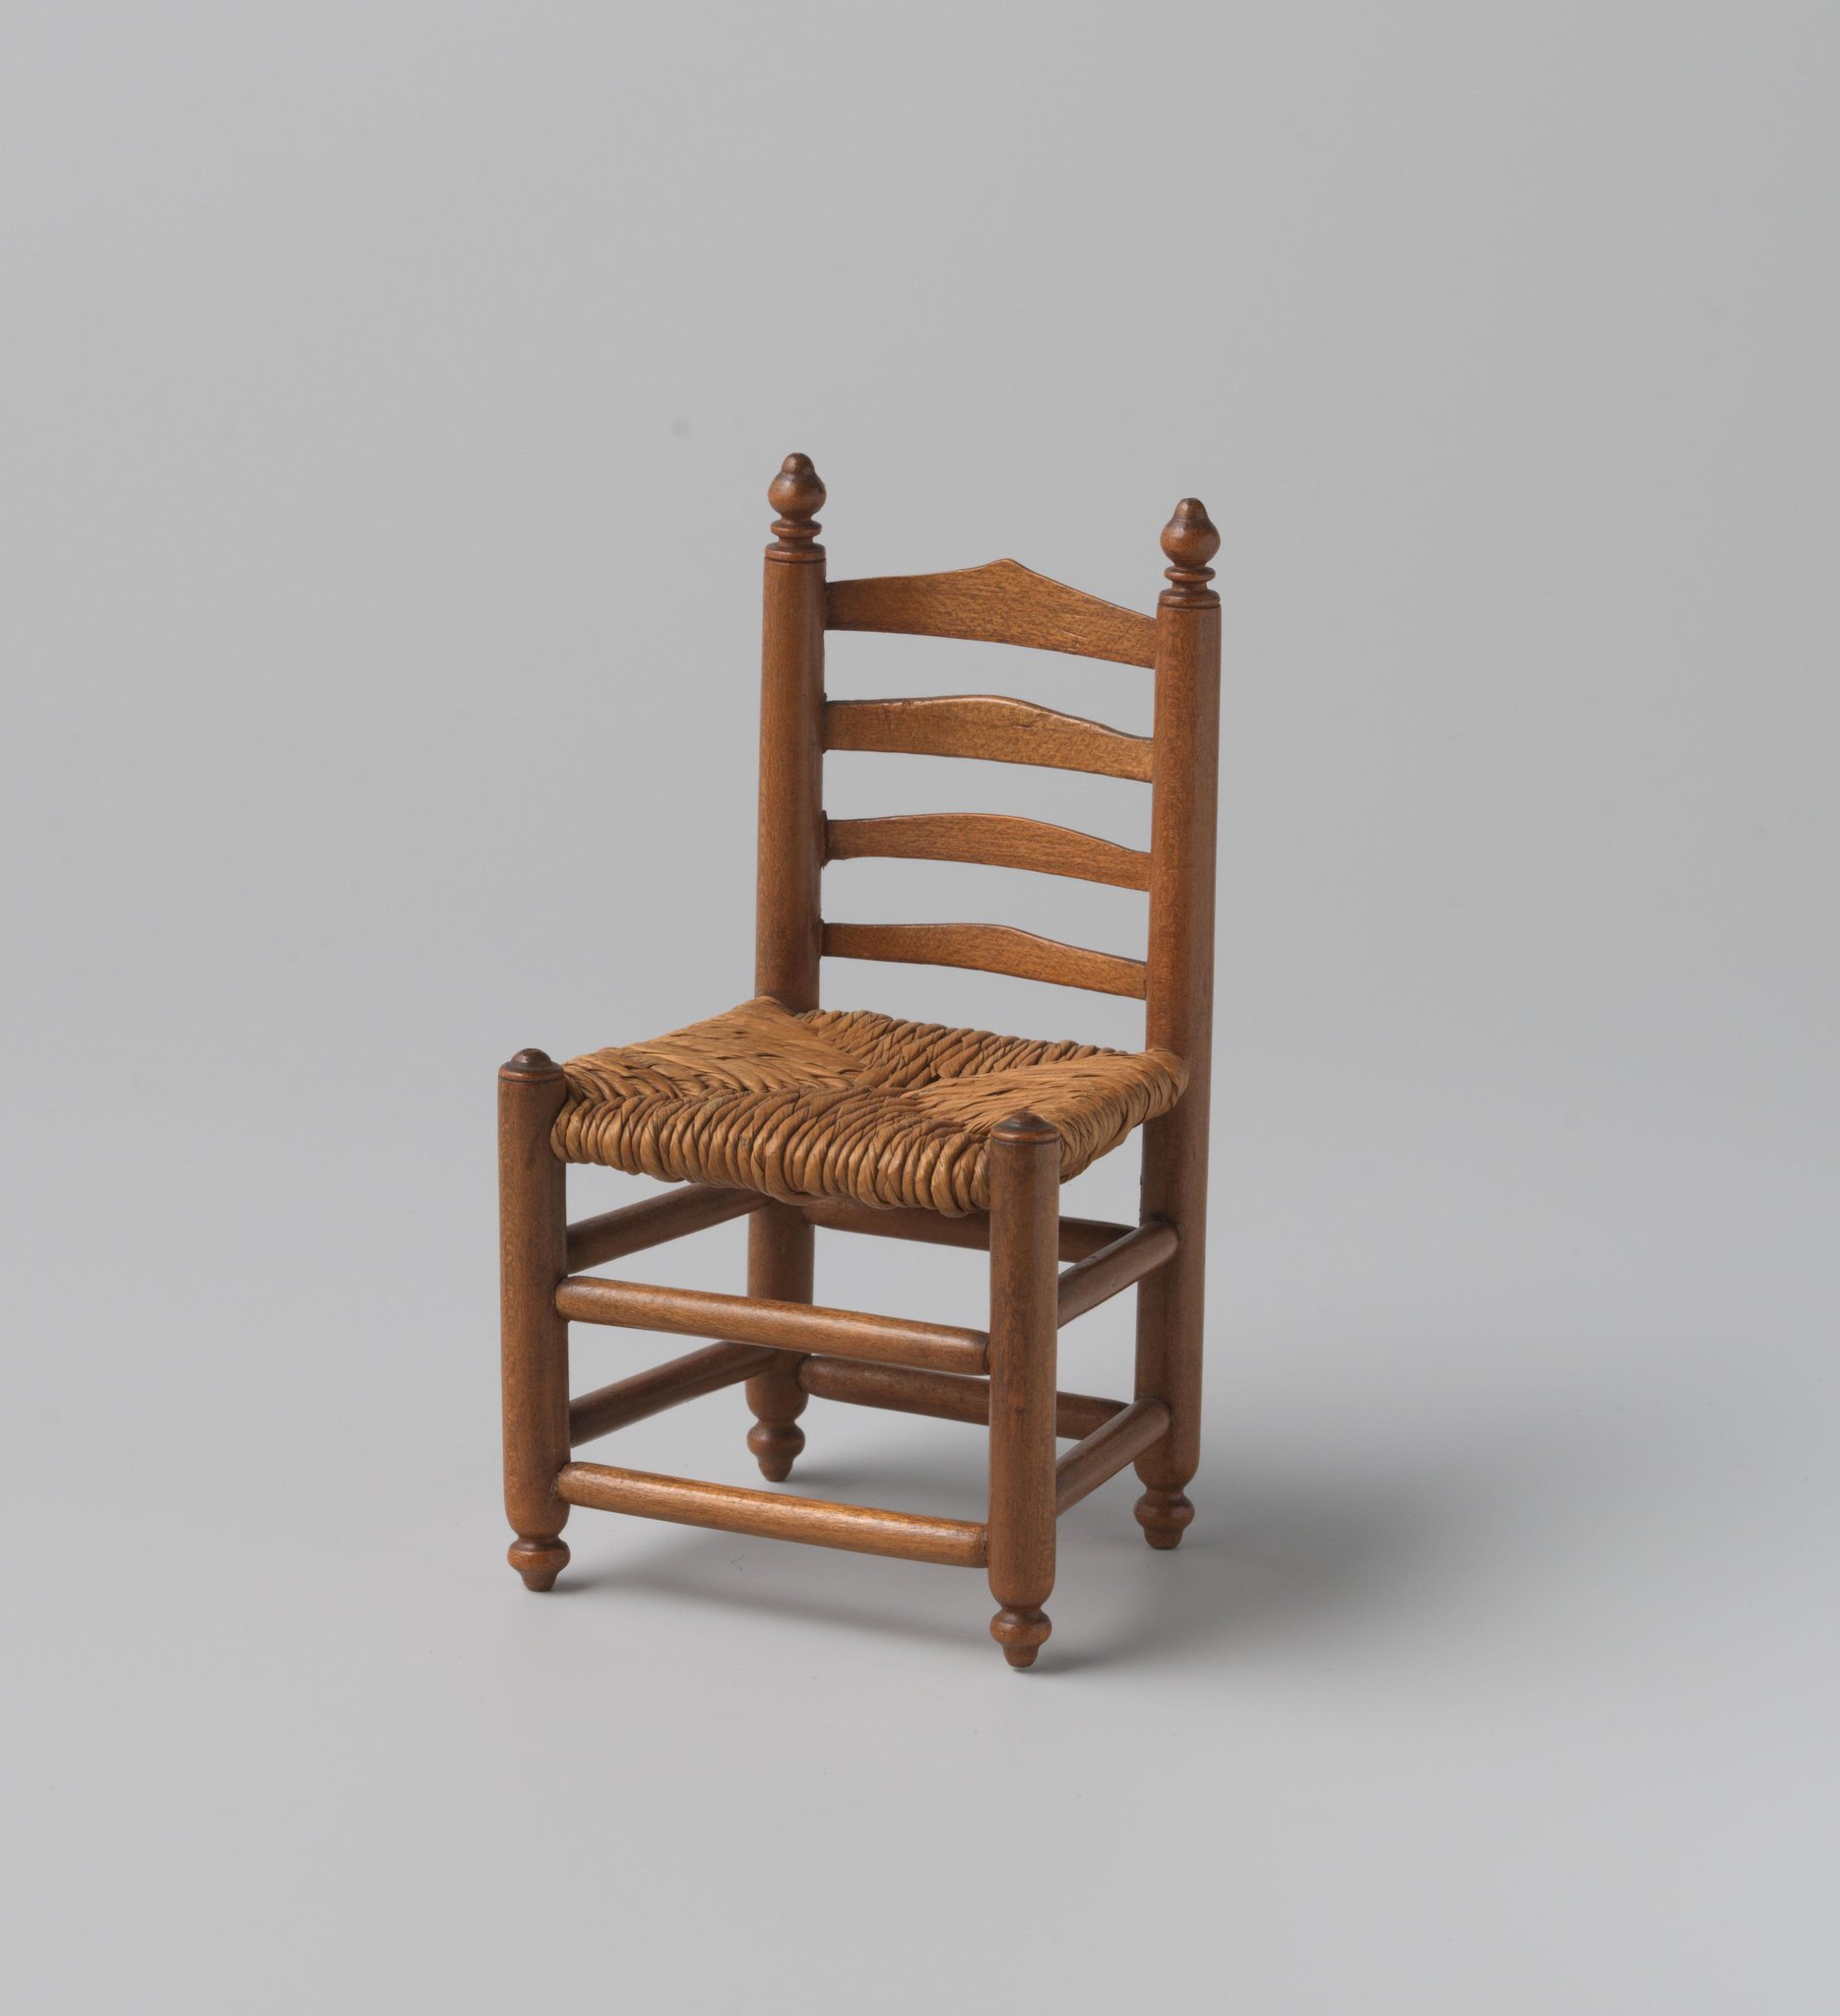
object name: miniature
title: Knopstoel met zitting van gevlochten biezen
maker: Anonymous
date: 1690-1710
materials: wood, fiber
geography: amsterdam